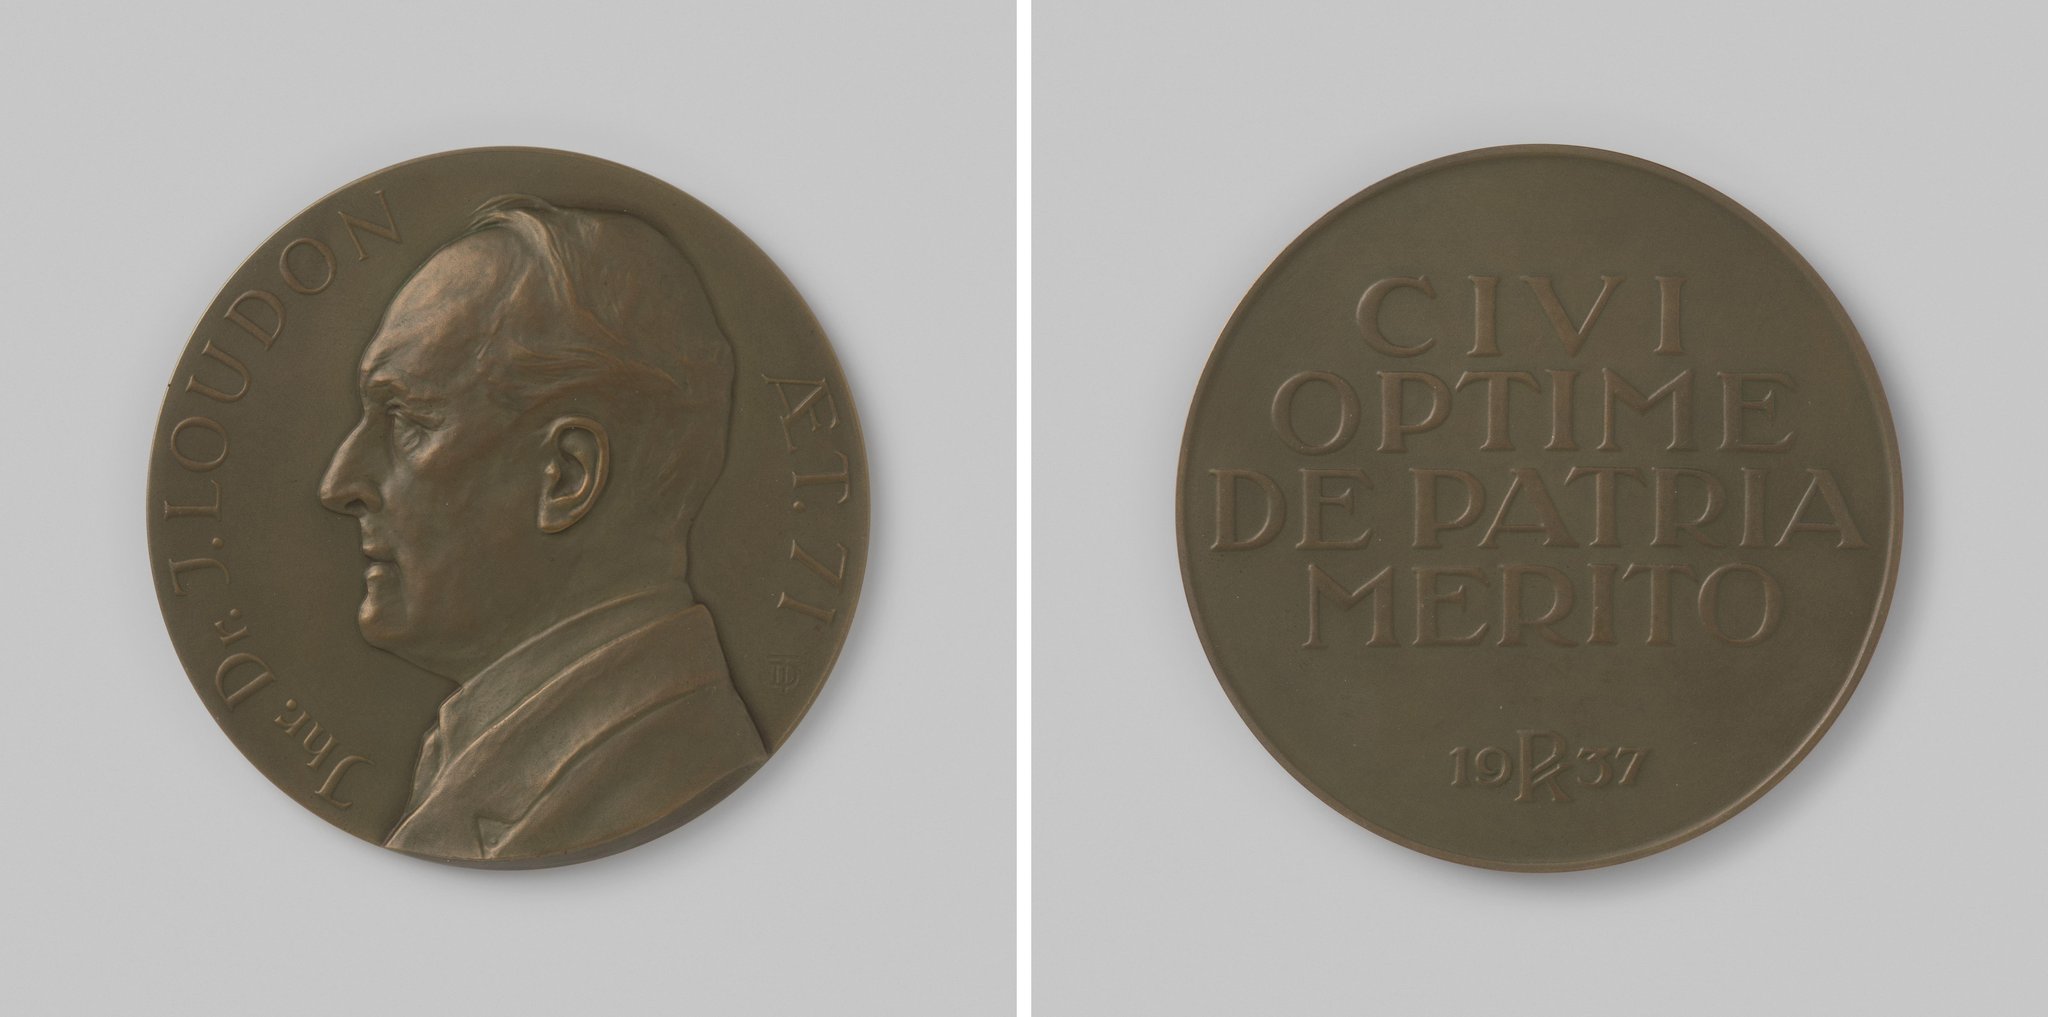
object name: medal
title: Jonkheer doctor J. Loudon (Vereniging voor Penningkunst 1937, tweede penning)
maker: toon dupuis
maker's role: sculptor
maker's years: 1877-1937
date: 1937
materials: bronze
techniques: casting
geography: netherlands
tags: jonkheer john loudon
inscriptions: signature: ‘PK’, circumscription: ‘Jhr Dr. J. Loudon Aet. 71’, inscription: ‘Civi optime de patria merito 1937’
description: Bronzen penning, vz kop van man naar links, en profil, met omschrift; kz tekst.